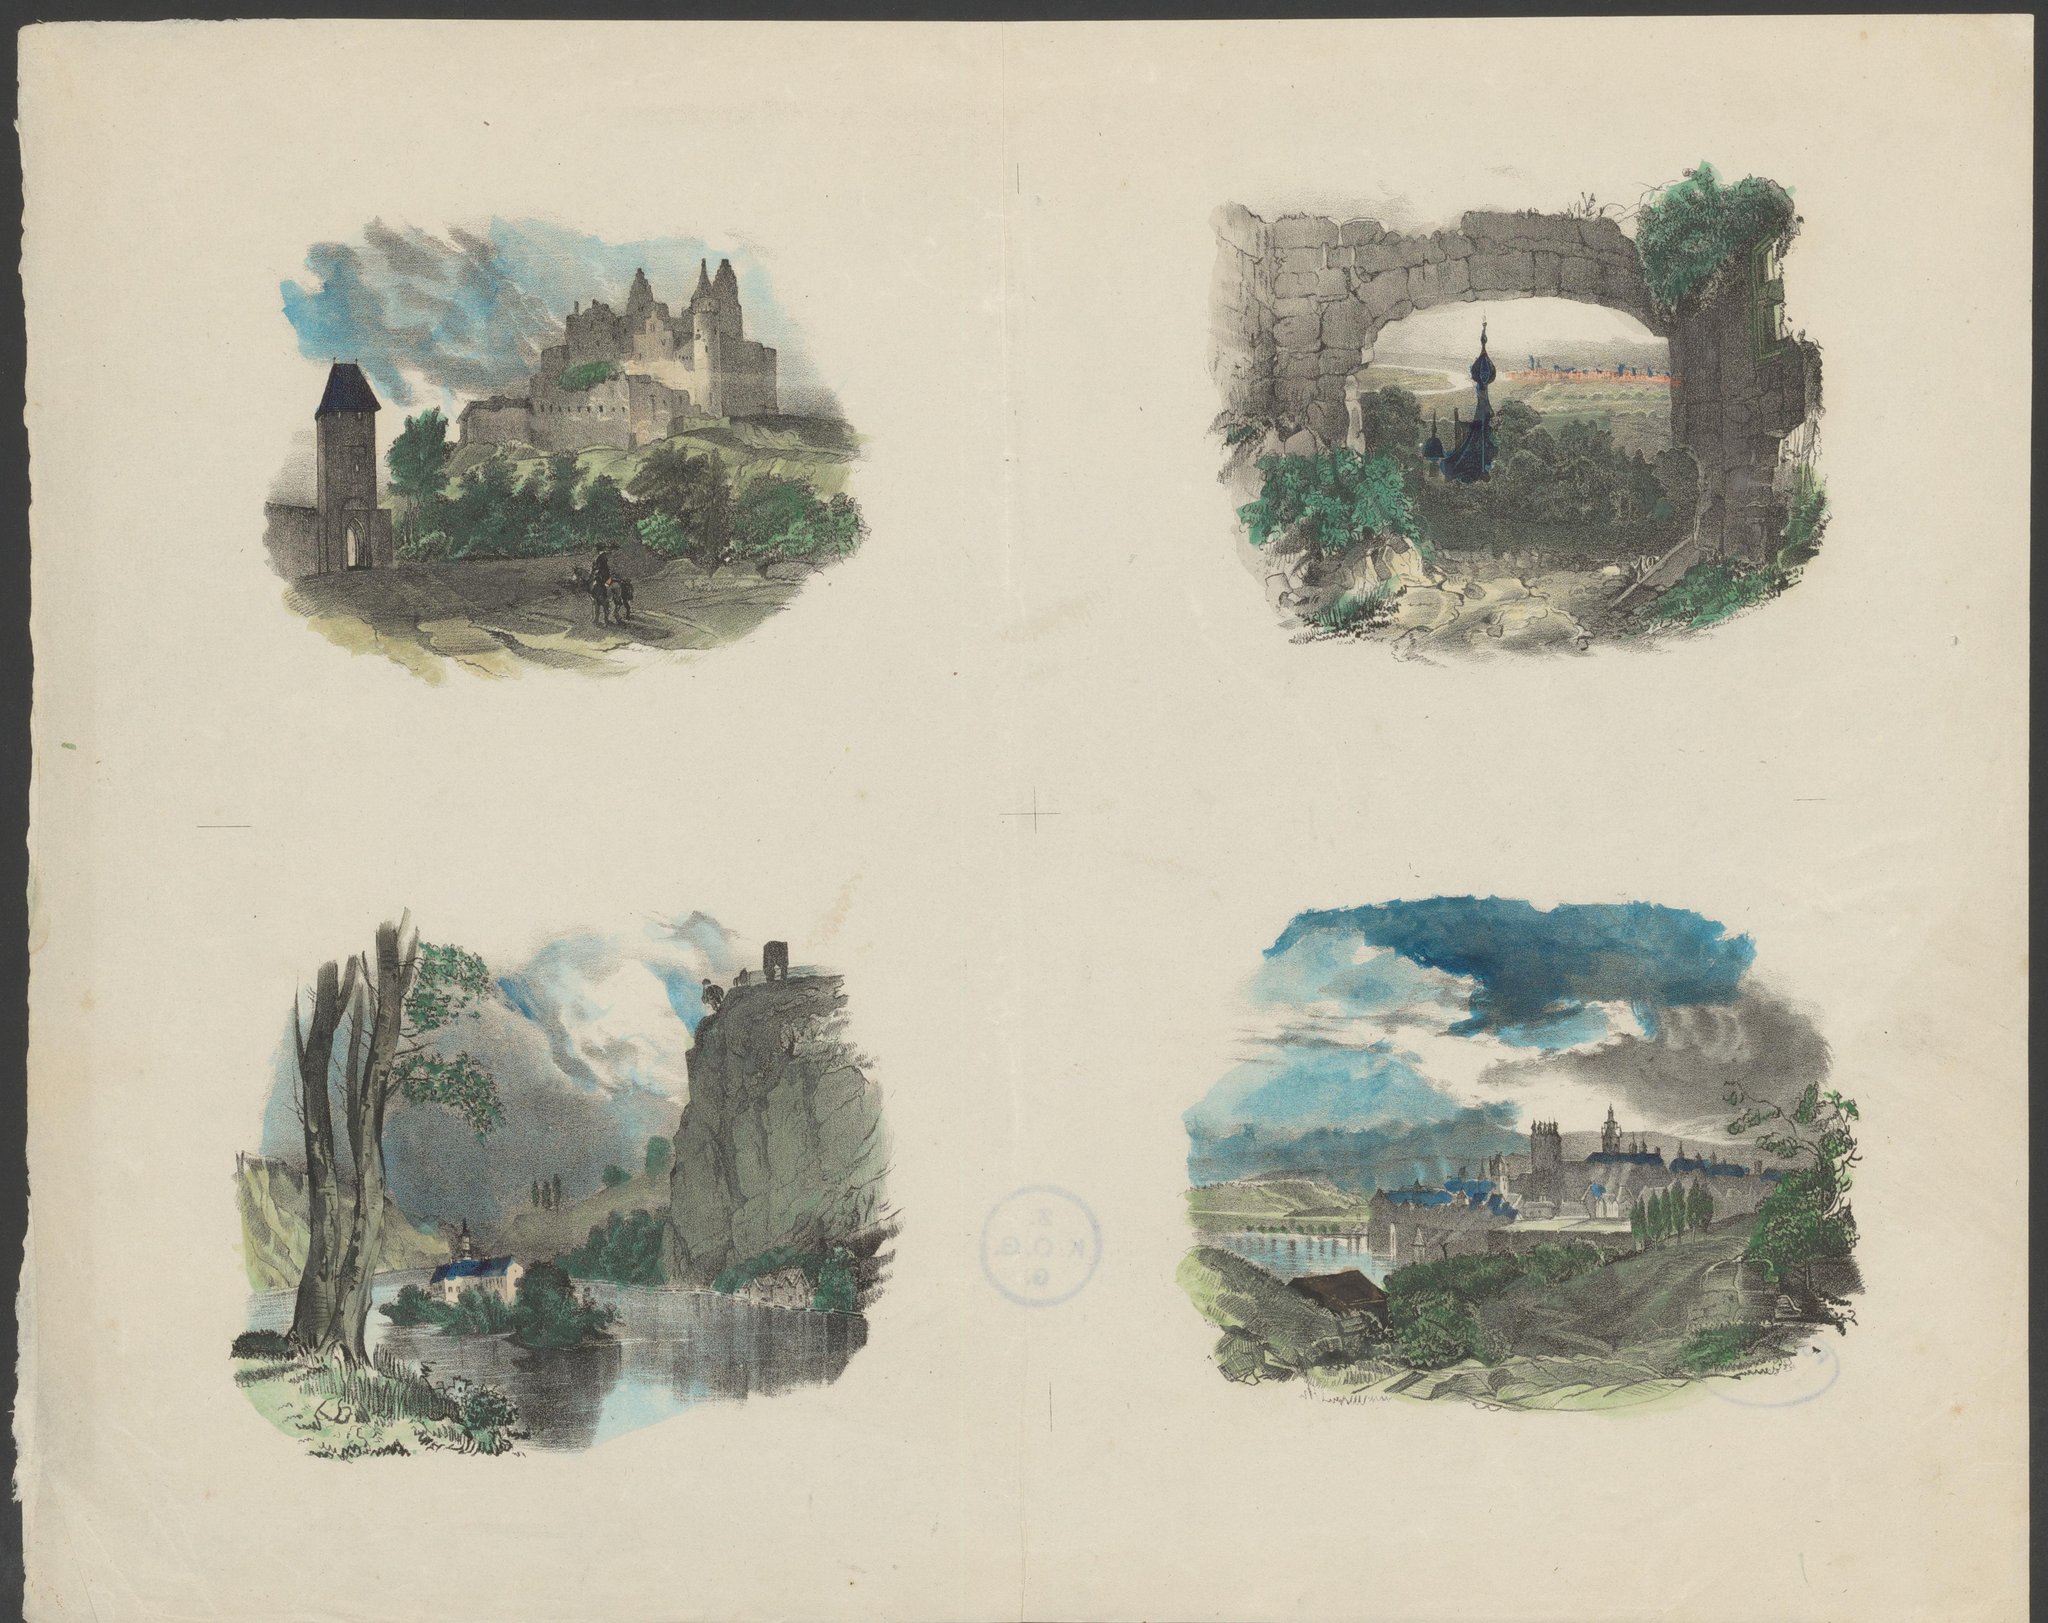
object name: print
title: Vier gezichten op kastelen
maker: Anonymous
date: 1800-1899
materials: paper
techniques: hand coloring, lithograph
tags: castle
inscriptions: collector's mark: Lugt 1641, stamp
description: Vier gezichten op kastelen. Onderwerpsrubrieken binnen de Atlas Zeden en Gewoonten: Zeden en Gewoonten in Engeren Zin, Des menschen beging, midden en einde, Kinderleven – Kinderspel en Kinderprenten.